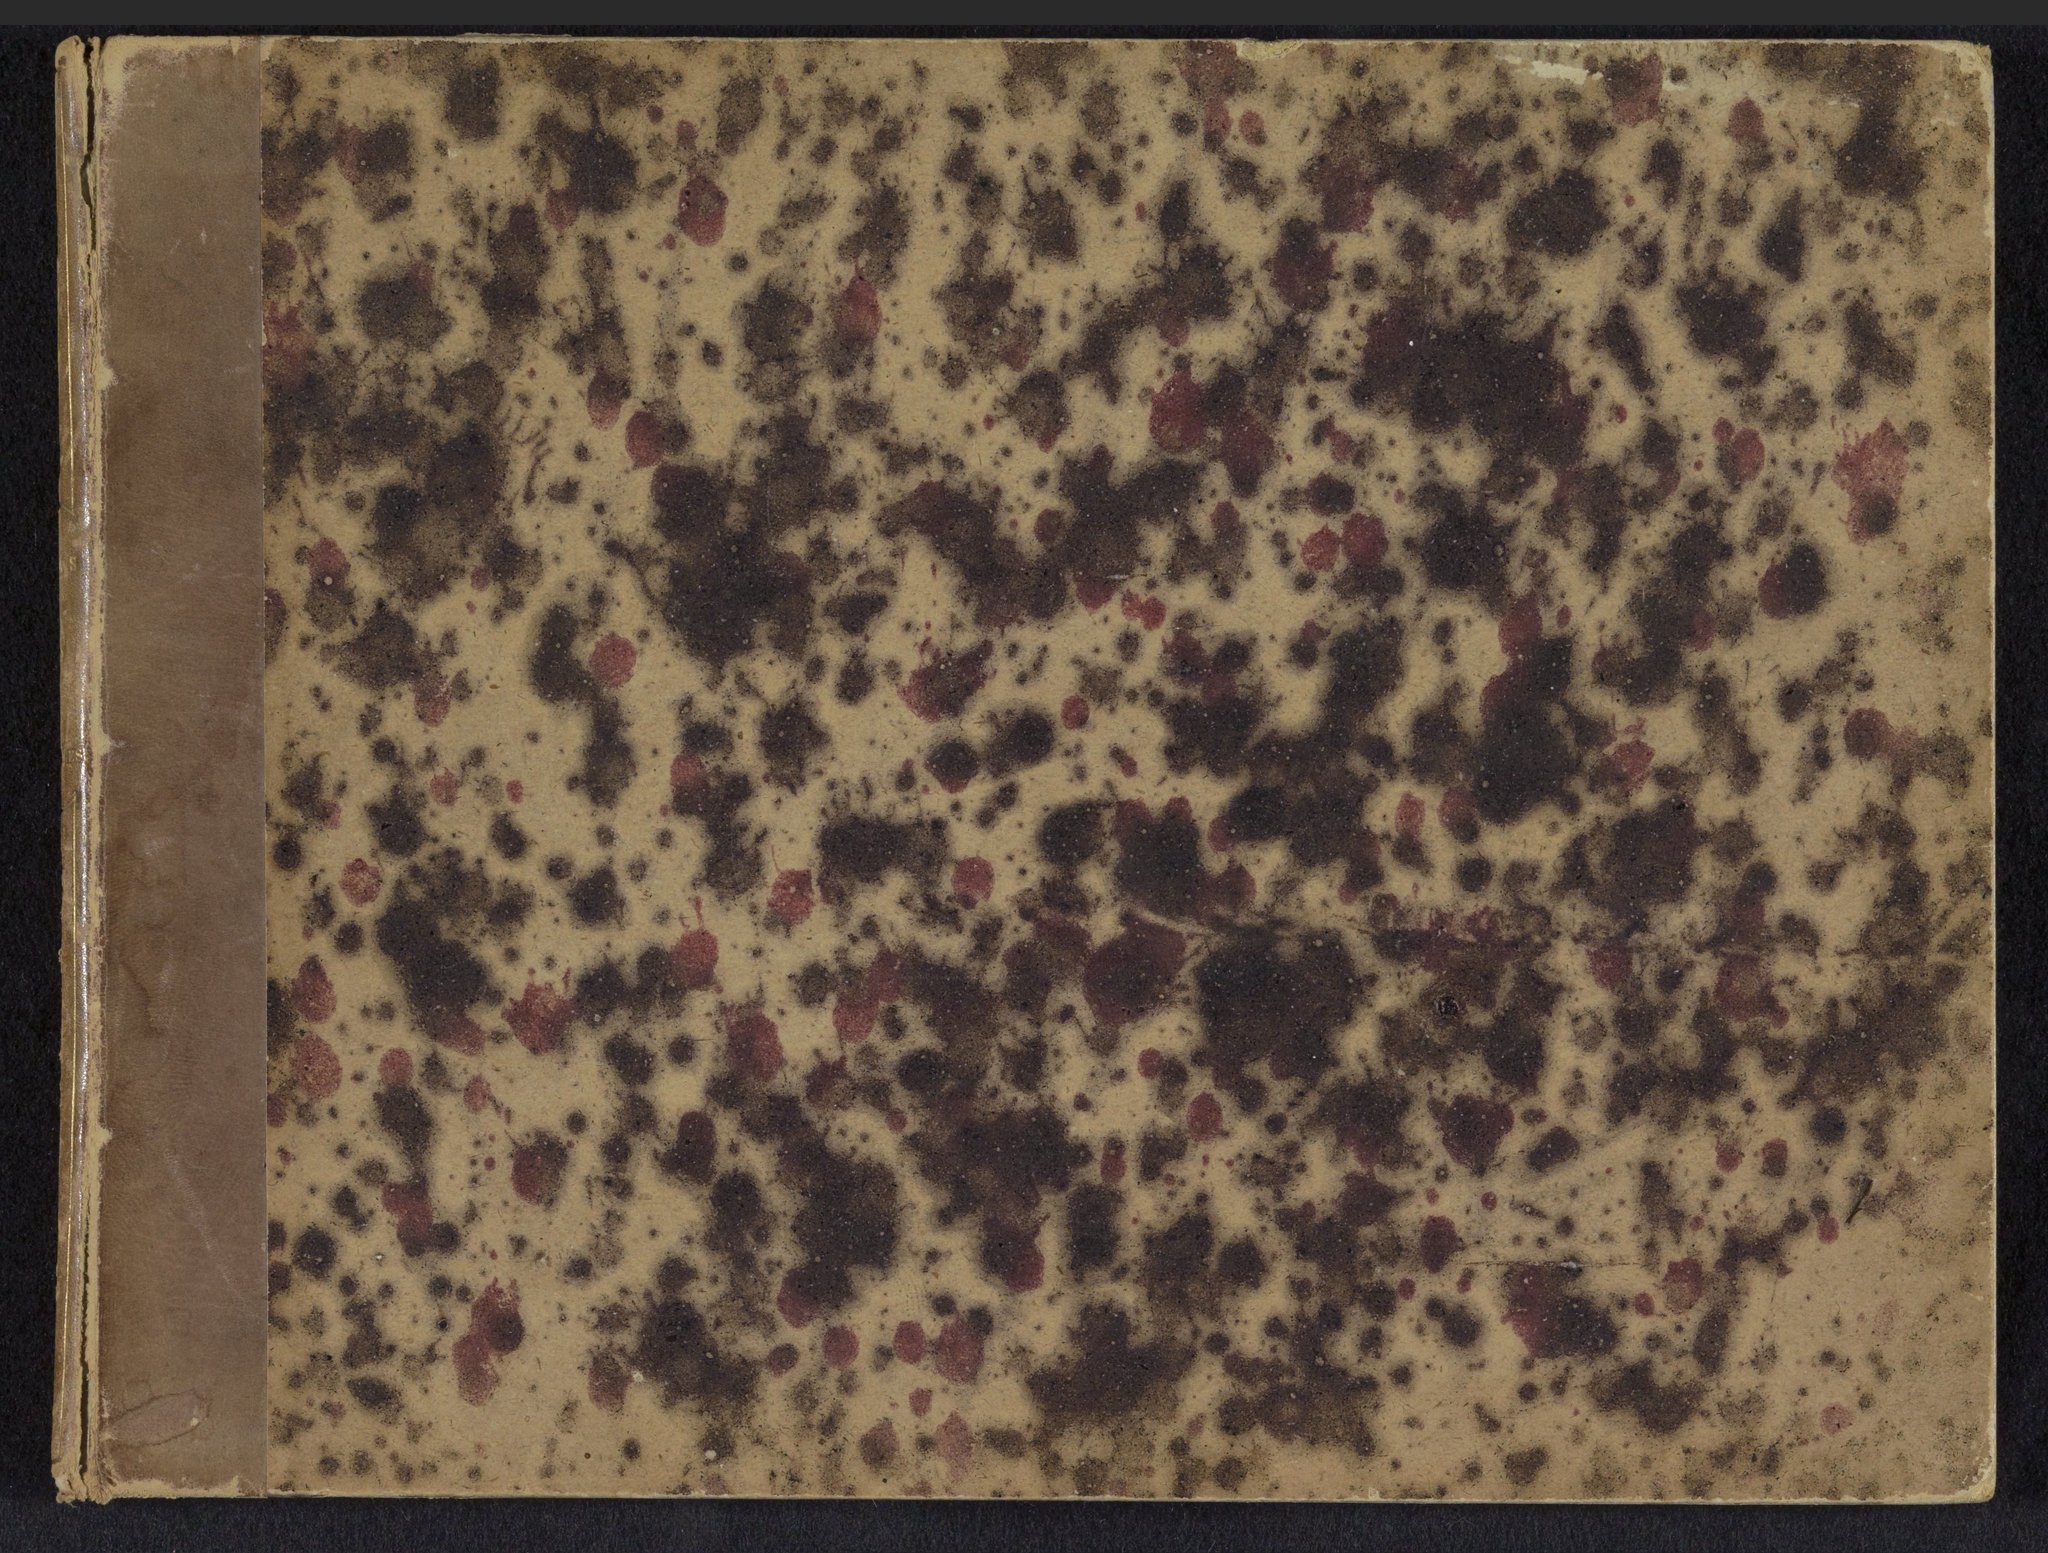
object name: prentrecueil, prentenalbum, prentalbum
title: Vues et Paysages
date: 1600-1699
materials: leather, paper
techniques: bookbinding, etching, marbling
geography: france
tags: city-view, and landscape with man-made constructions, landscapes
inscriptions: collector's mark: Lugt 2228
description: Album met dertig voorstellingen op dertig albumbladen. Het gaat om drie series van acht, vier en acht landschappen van Charles (Carel) de Hooch, drie voorstellingen gekopieerd naar De Hooch. Daarna volgen een kopie naar Jacques Callot, vijf prenten van een anonieme Franse graveur en één prent naar een tekening van Leprince. Half leren bruine band met gemarmerde platten, voorin en achterin één of twee schutbladen.